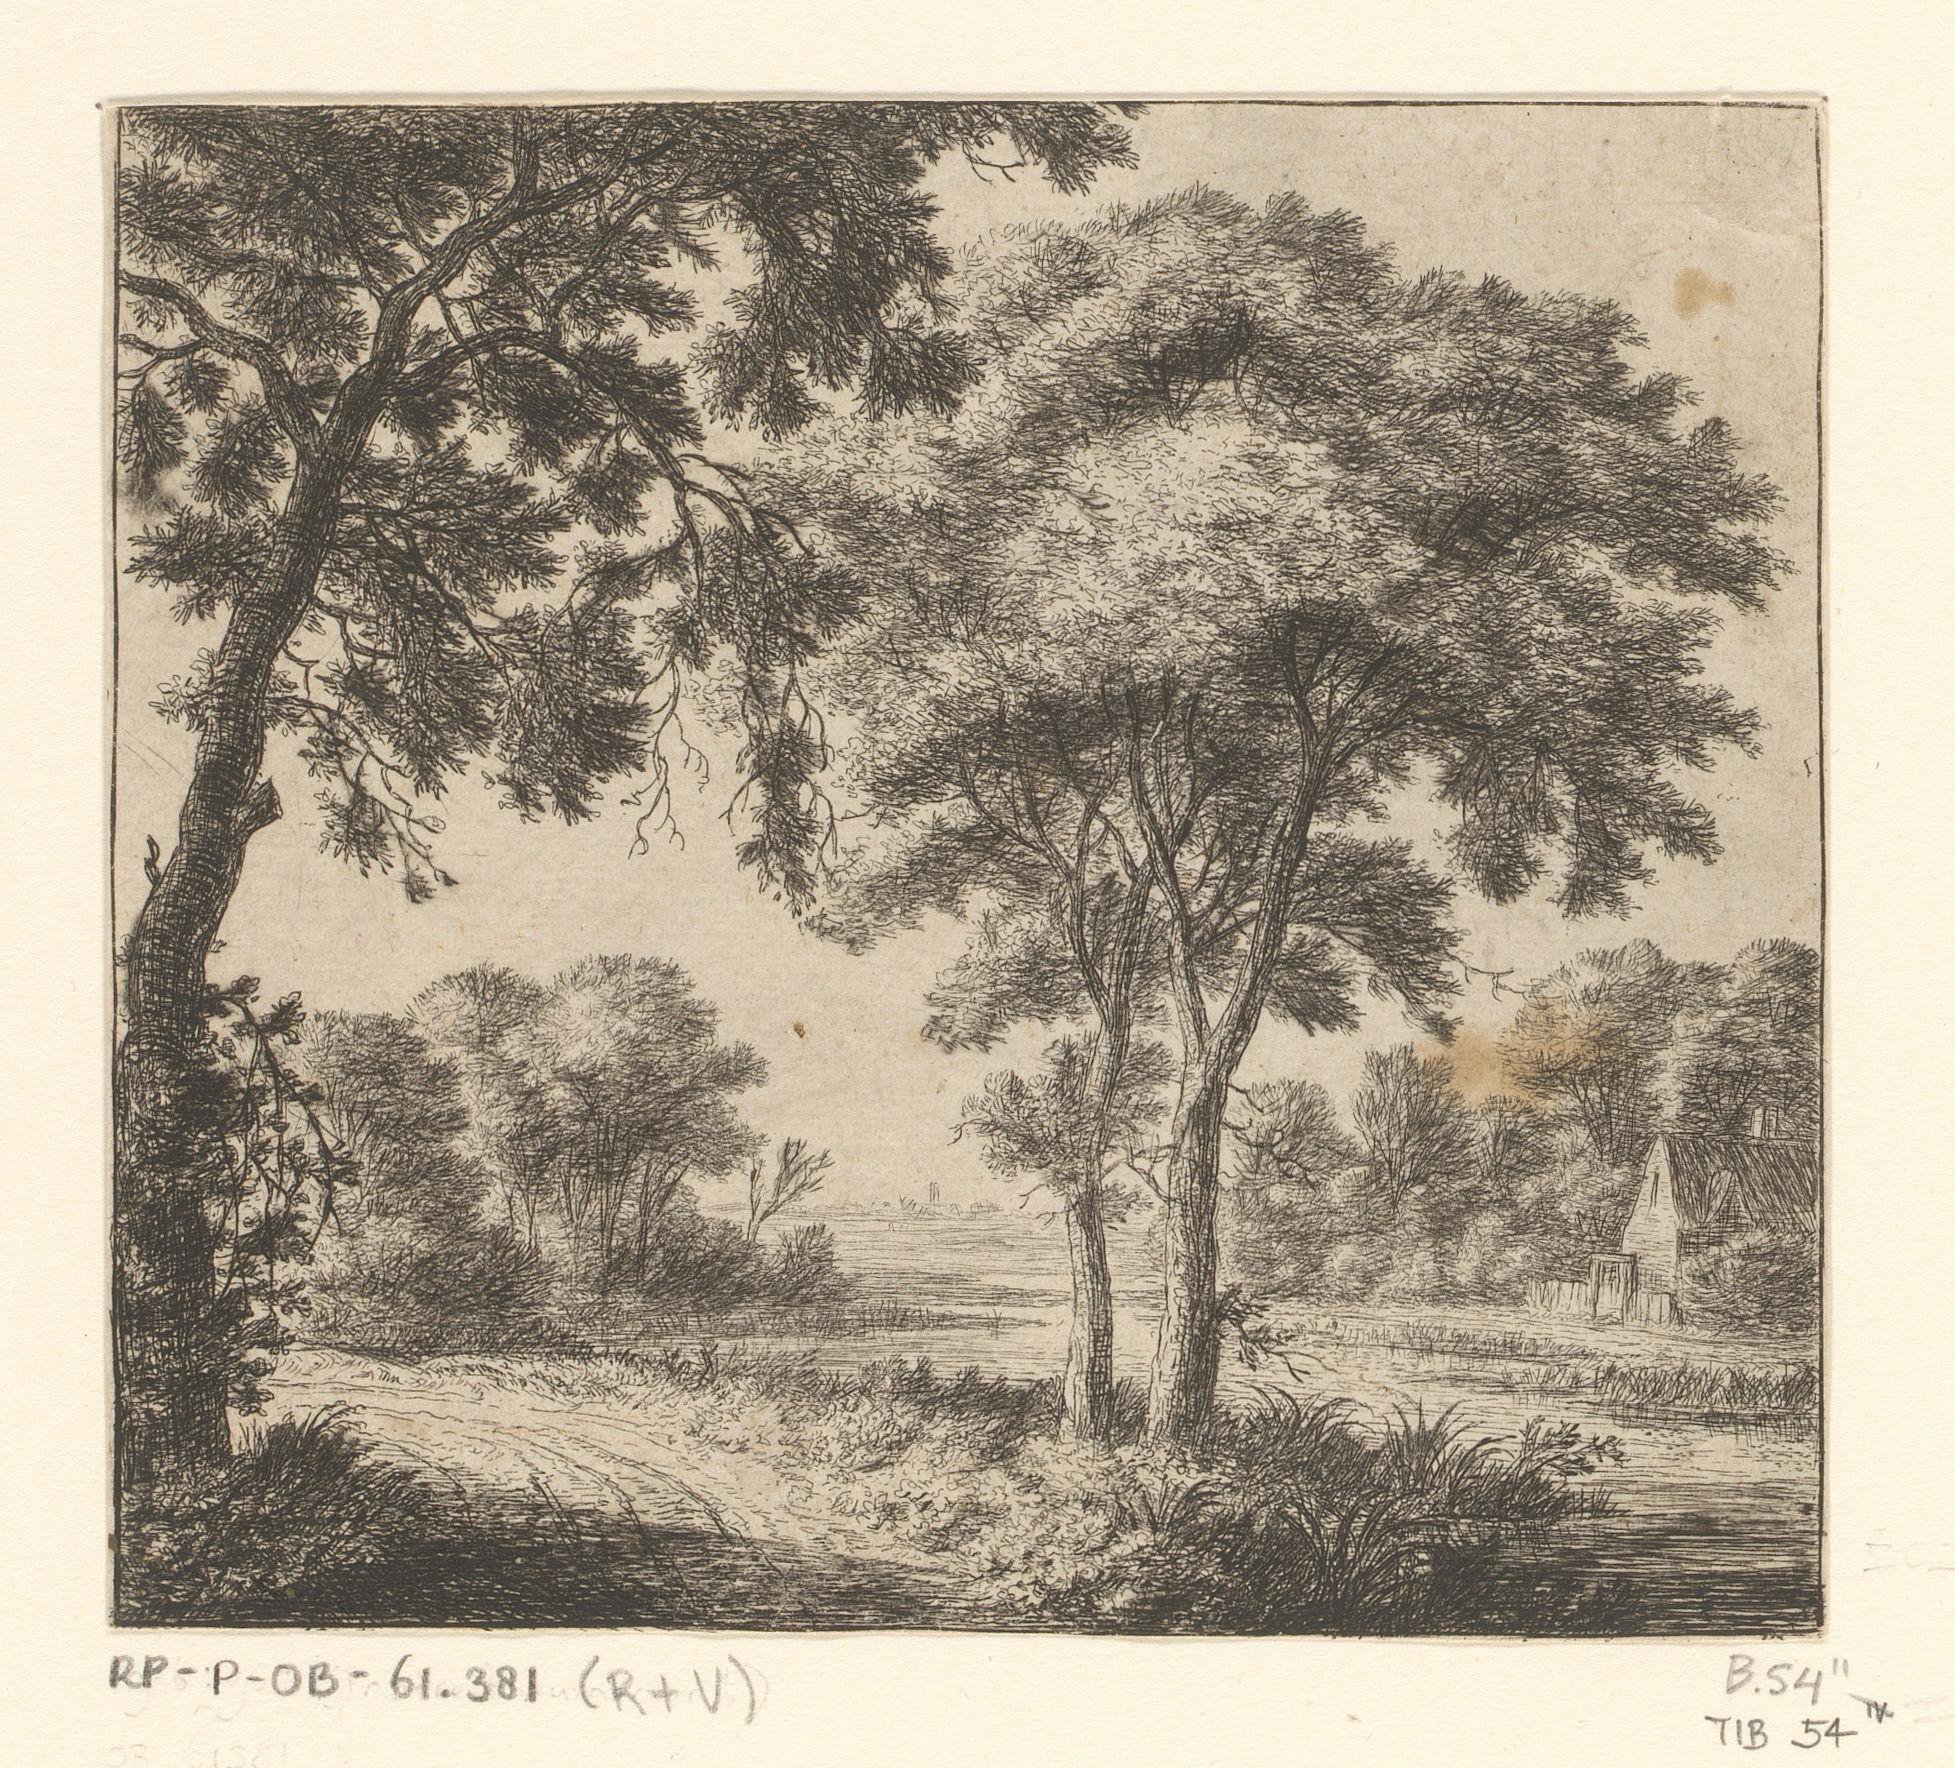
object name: print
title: Huis aan de oever van een rivier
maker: anthonie waterloo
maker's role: draughtsman, painter, print maker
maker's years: 1609-1690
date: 1630-1663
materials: paper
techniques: etching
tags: river, rural housing, e.g. country-house, villa, cottage, forest, wood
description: Zie RP-P-OB-61.381(V) voor de versozijde. Zie Hollstein voor een volledig overzicht van de verschillende edities.